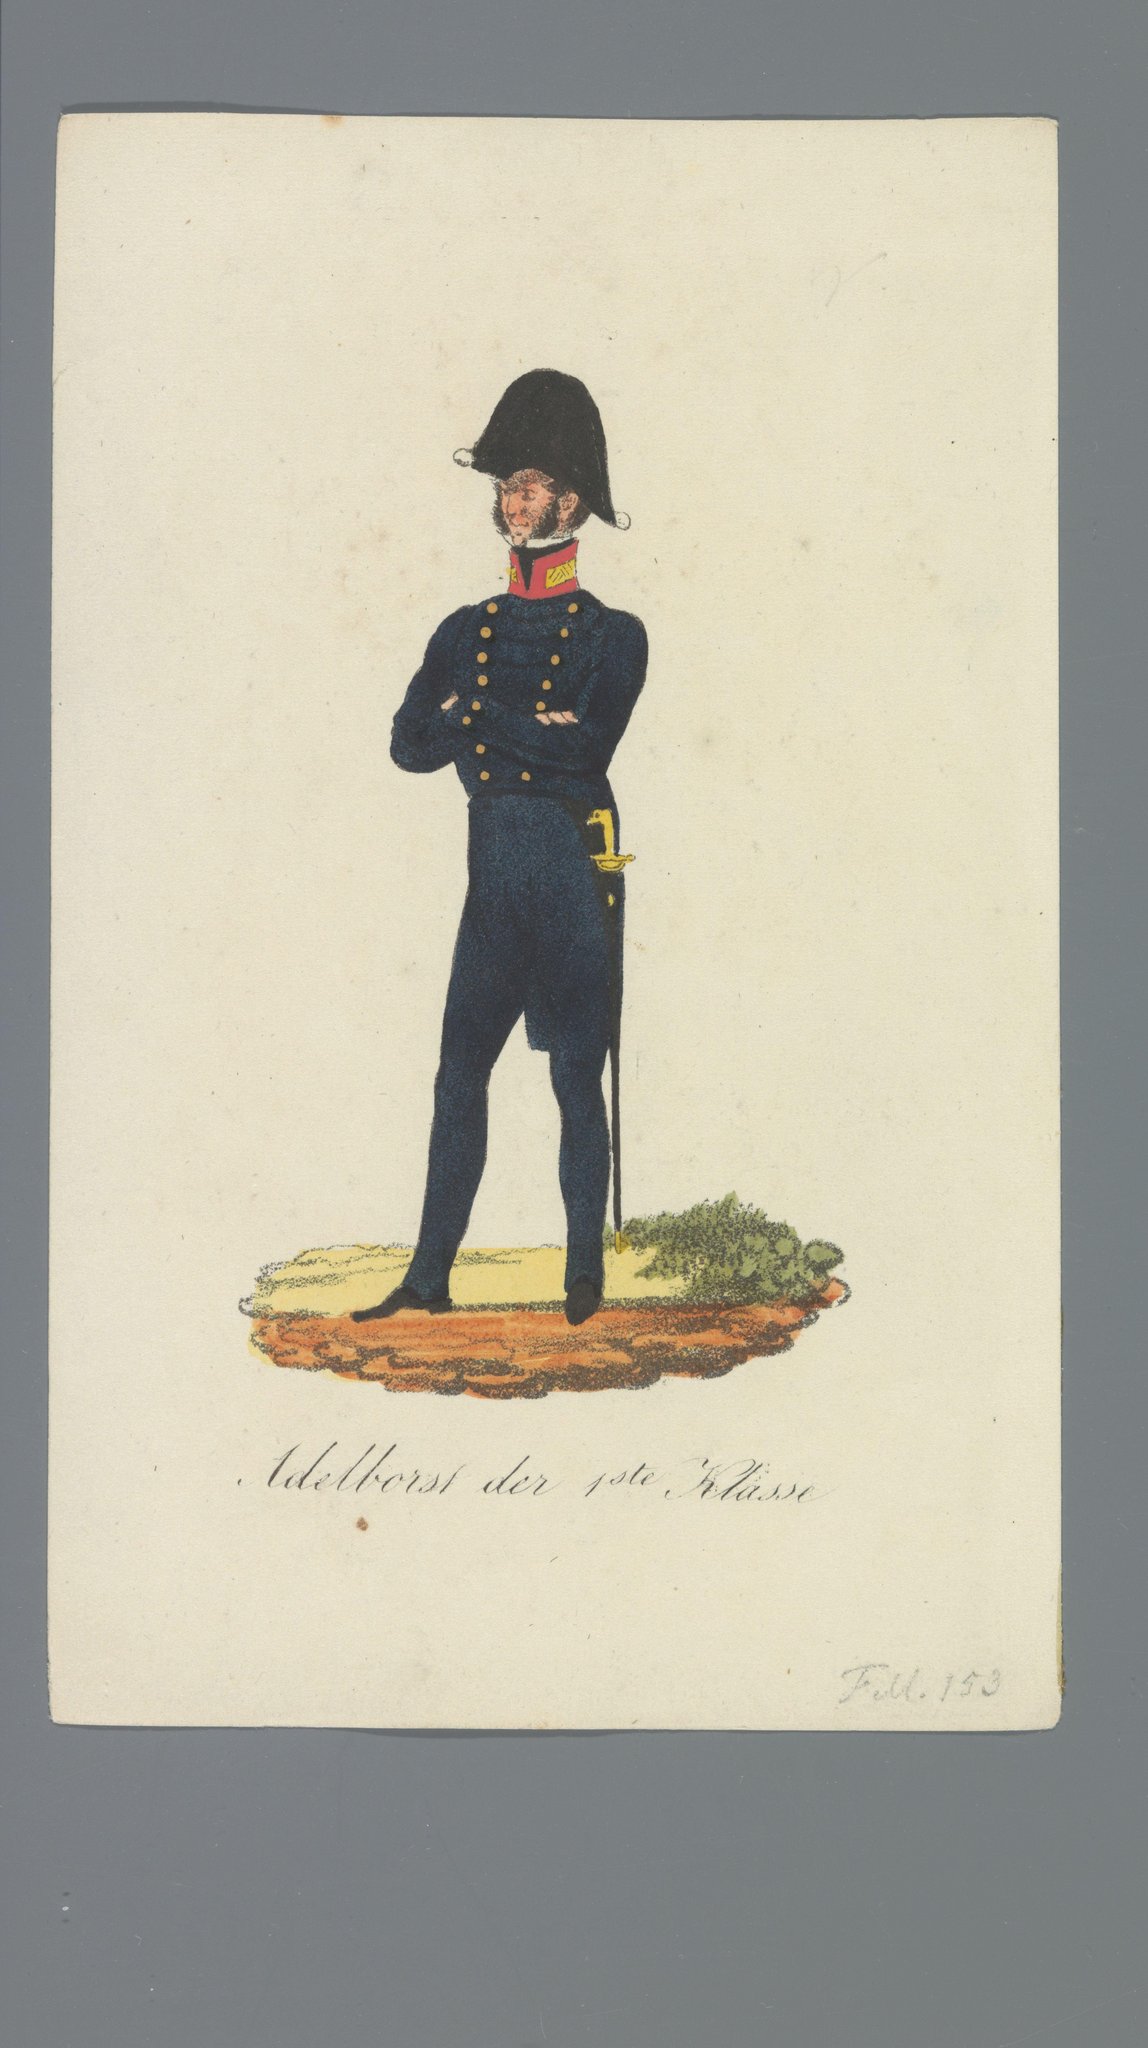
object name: print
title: Adelborst der 1ste Klasse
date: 1835-1850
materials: paper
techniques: hand coloring, lithograph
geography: utrecht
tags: (military) uniforms, clothes, costume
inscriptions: collector's mark: Lugt 2228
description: Een adelborst eerste klasse van de Marine, te voet. Onderdeel van een serie van 157 losse bladen met Nederlandse militaire uniformen in de jaren 1830-1832.